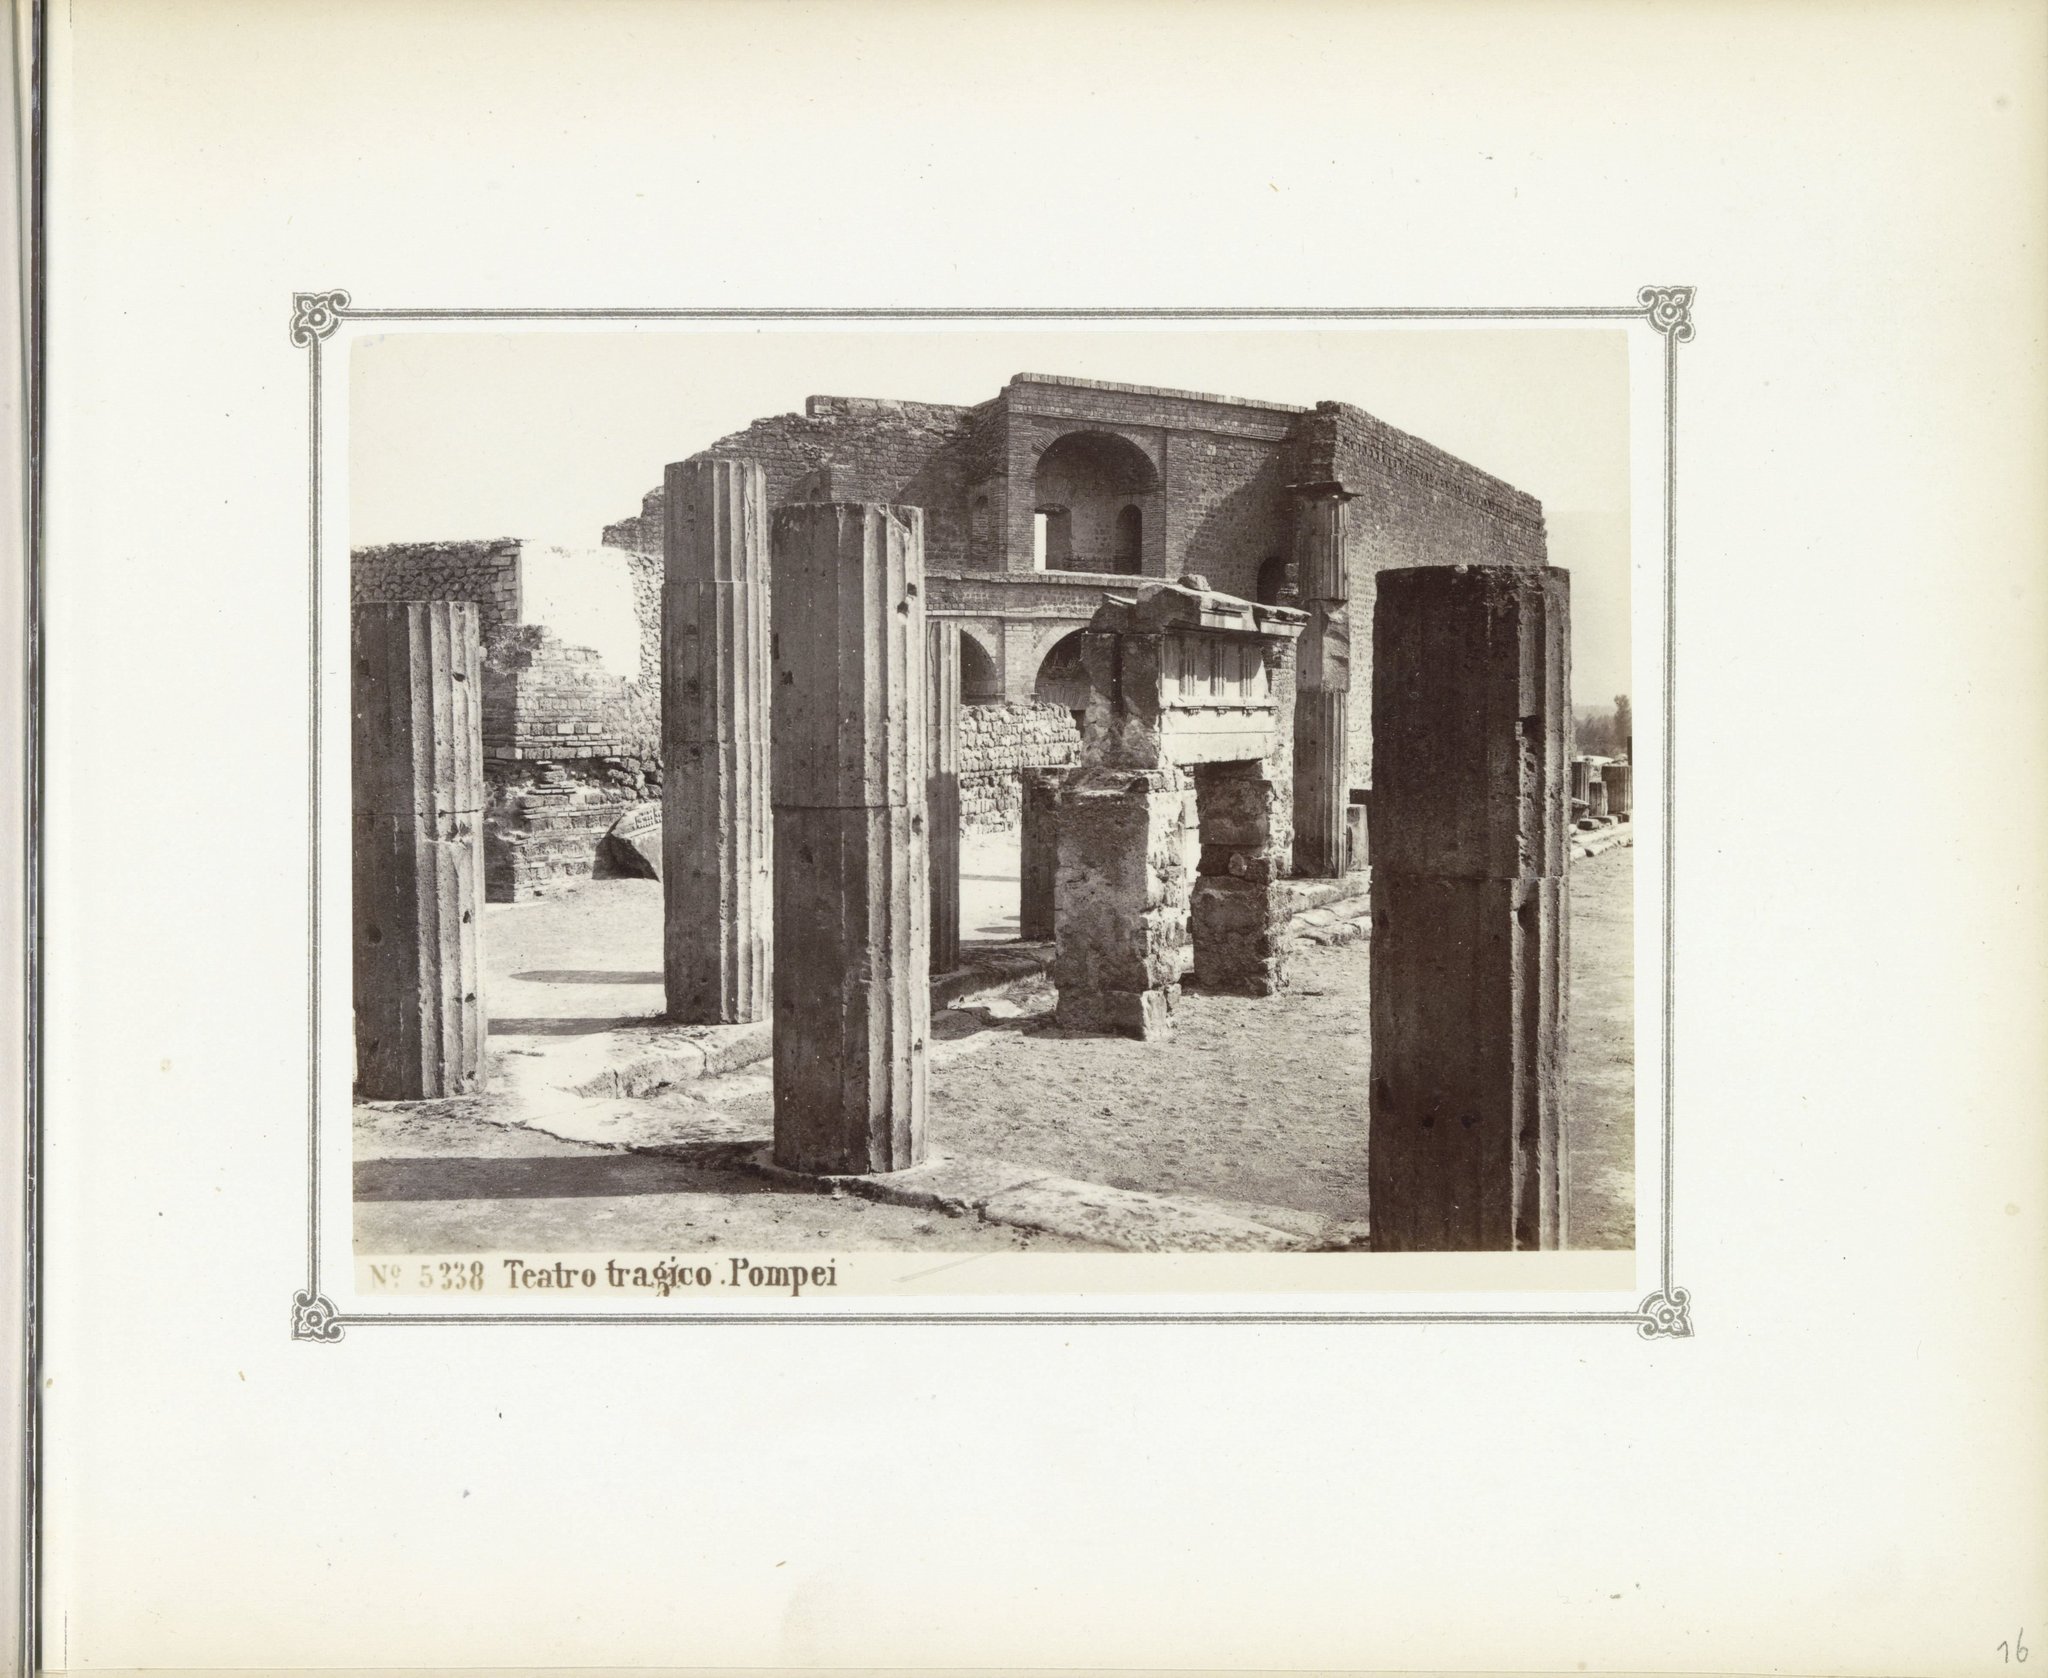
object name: photograph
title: Restanten van een theater in Pompeï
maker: giorgio sommer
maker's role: fotograaf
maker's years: 1834-1914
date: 1860-1900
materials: paper, photographic support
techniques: albumen print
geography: pompeii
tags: theatre (building), excavation ~ archaeology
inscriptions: number: ‘5338’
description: Onderdeel van Fotoalbum met opnames van opgravingen in Pompeï door Giorgio Sommer.